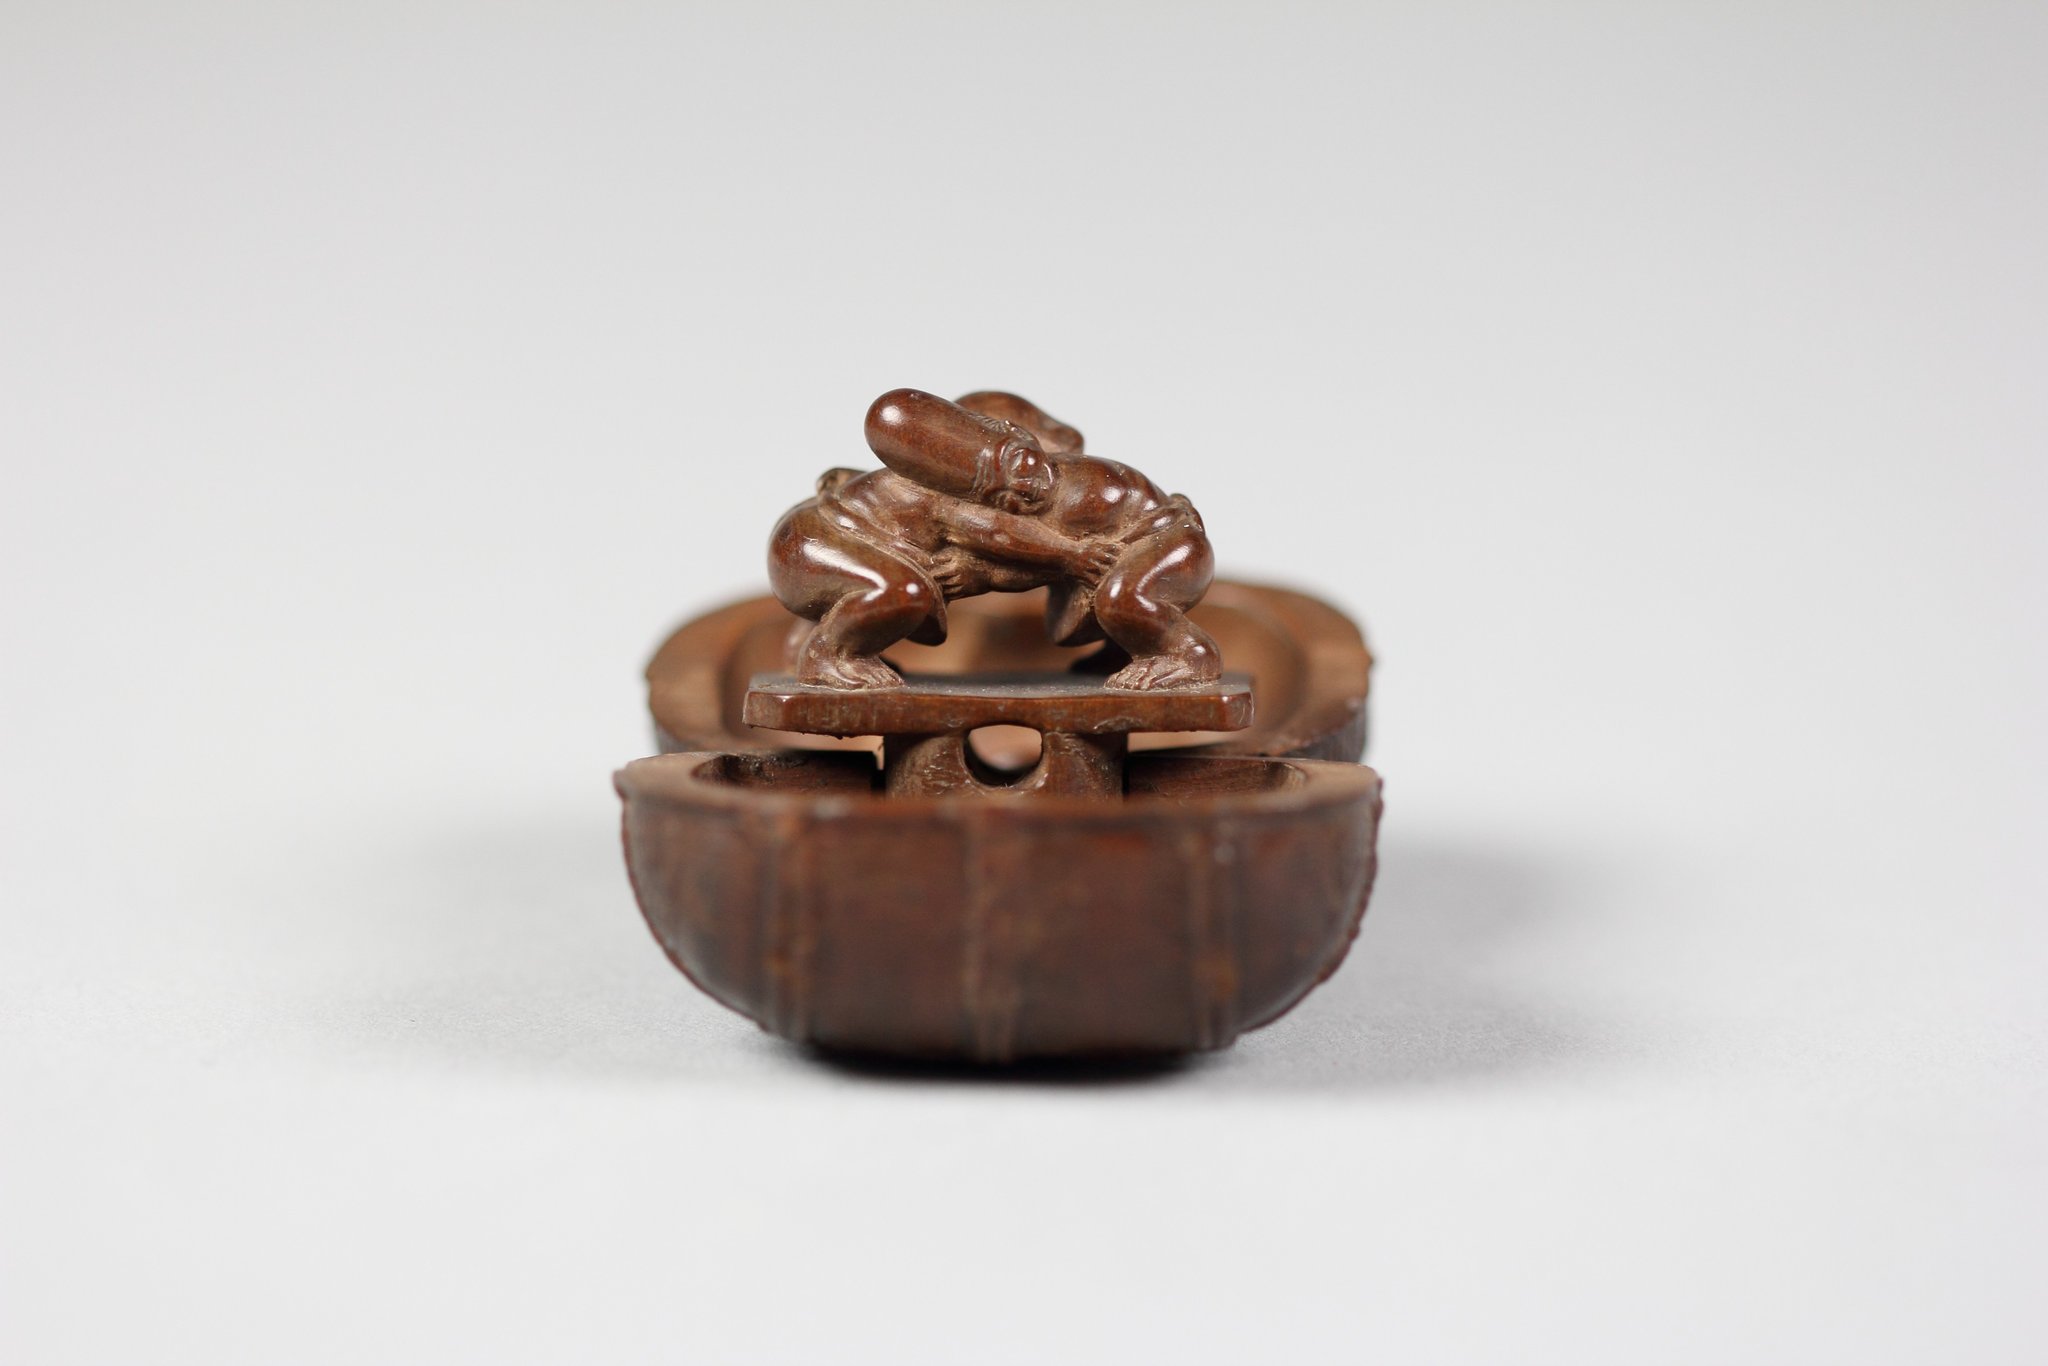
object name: netsuke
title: Netsuke of Bale of Rice; Inside are Daikoku and Fukurukujin, Wrestling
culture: japanese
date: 1701-1900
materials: wood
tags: men